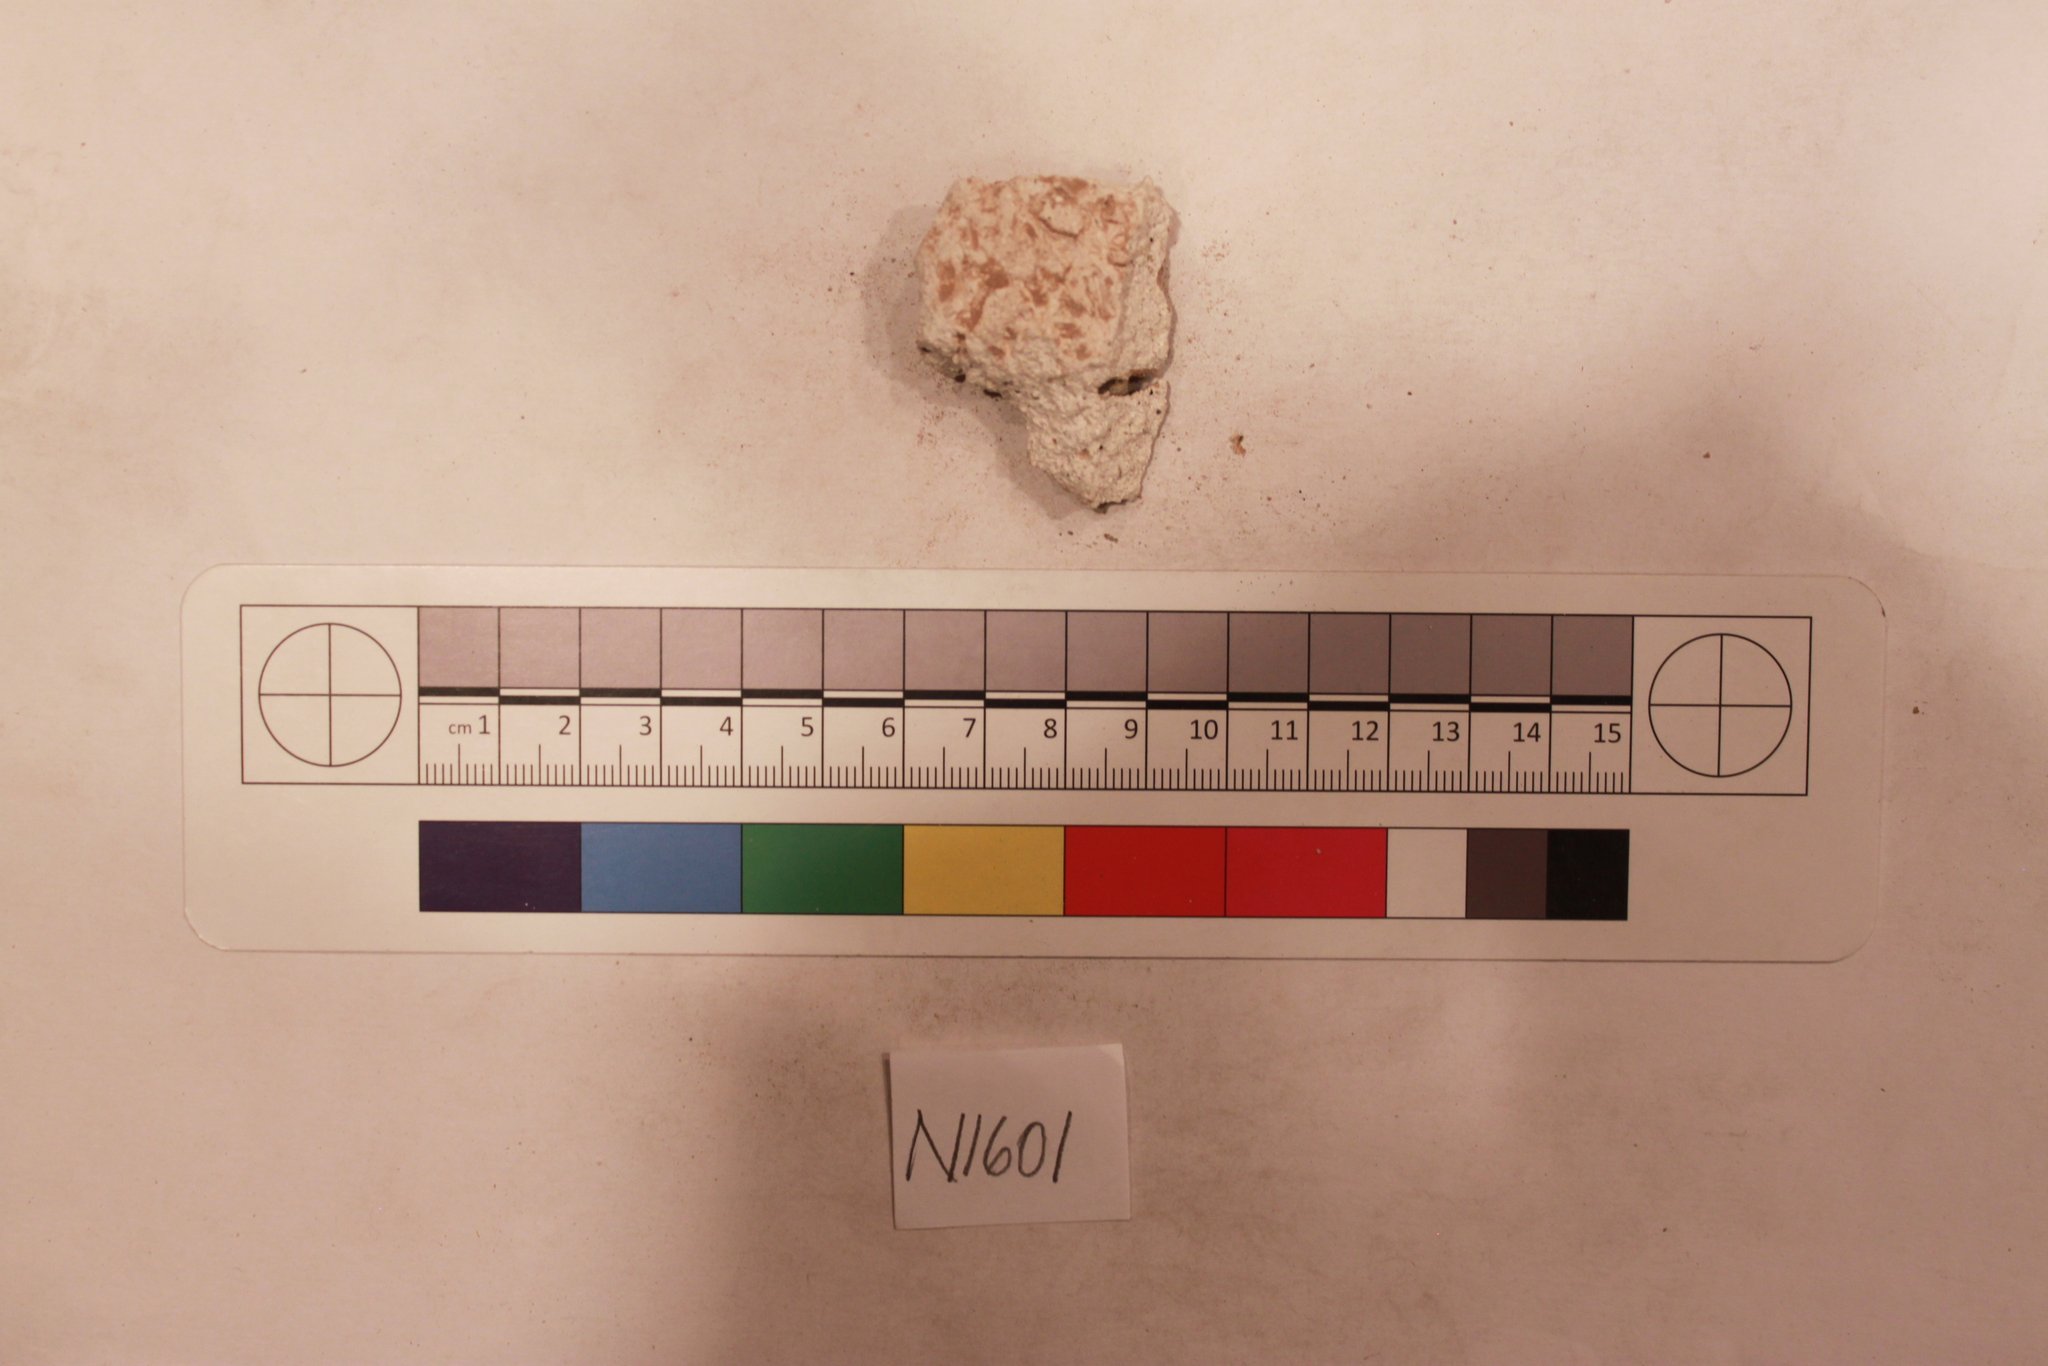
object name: fragment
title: Stucco Fragment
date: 701-1200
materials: plaster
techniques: carving, painting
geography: iran